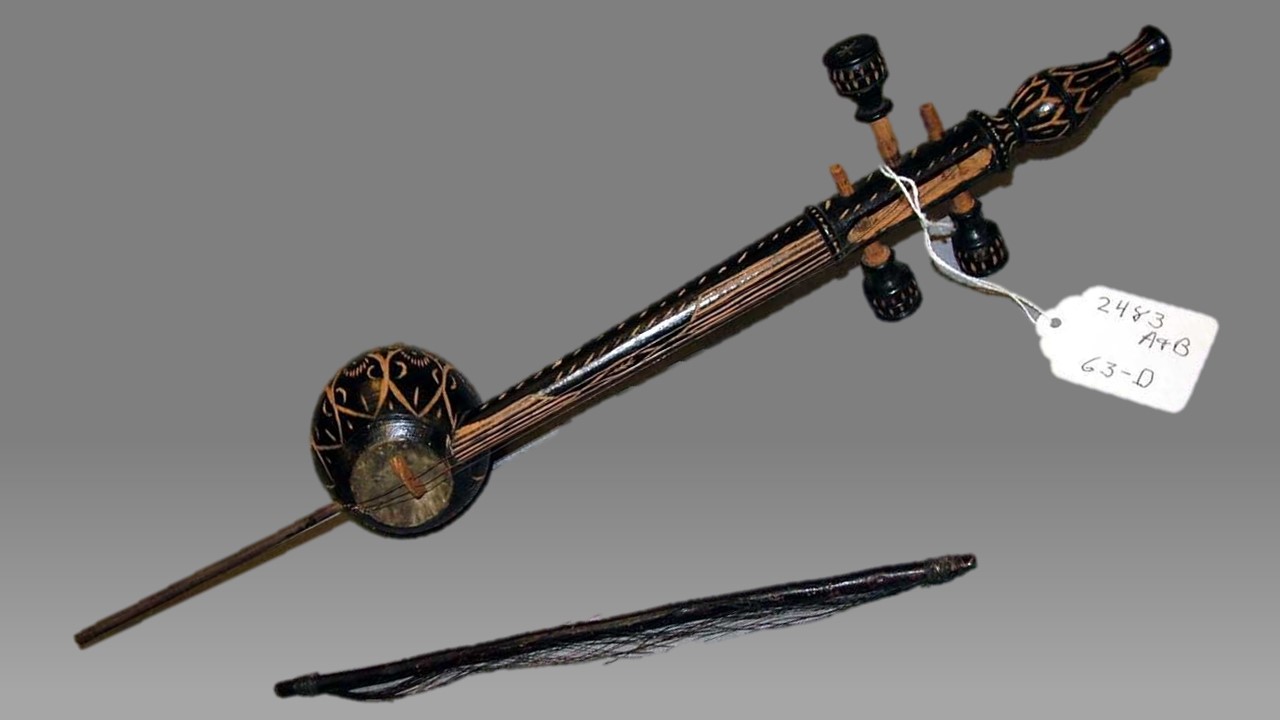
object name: kemangeh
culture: turkish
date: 1850-1889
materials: metal, wood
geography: turkey